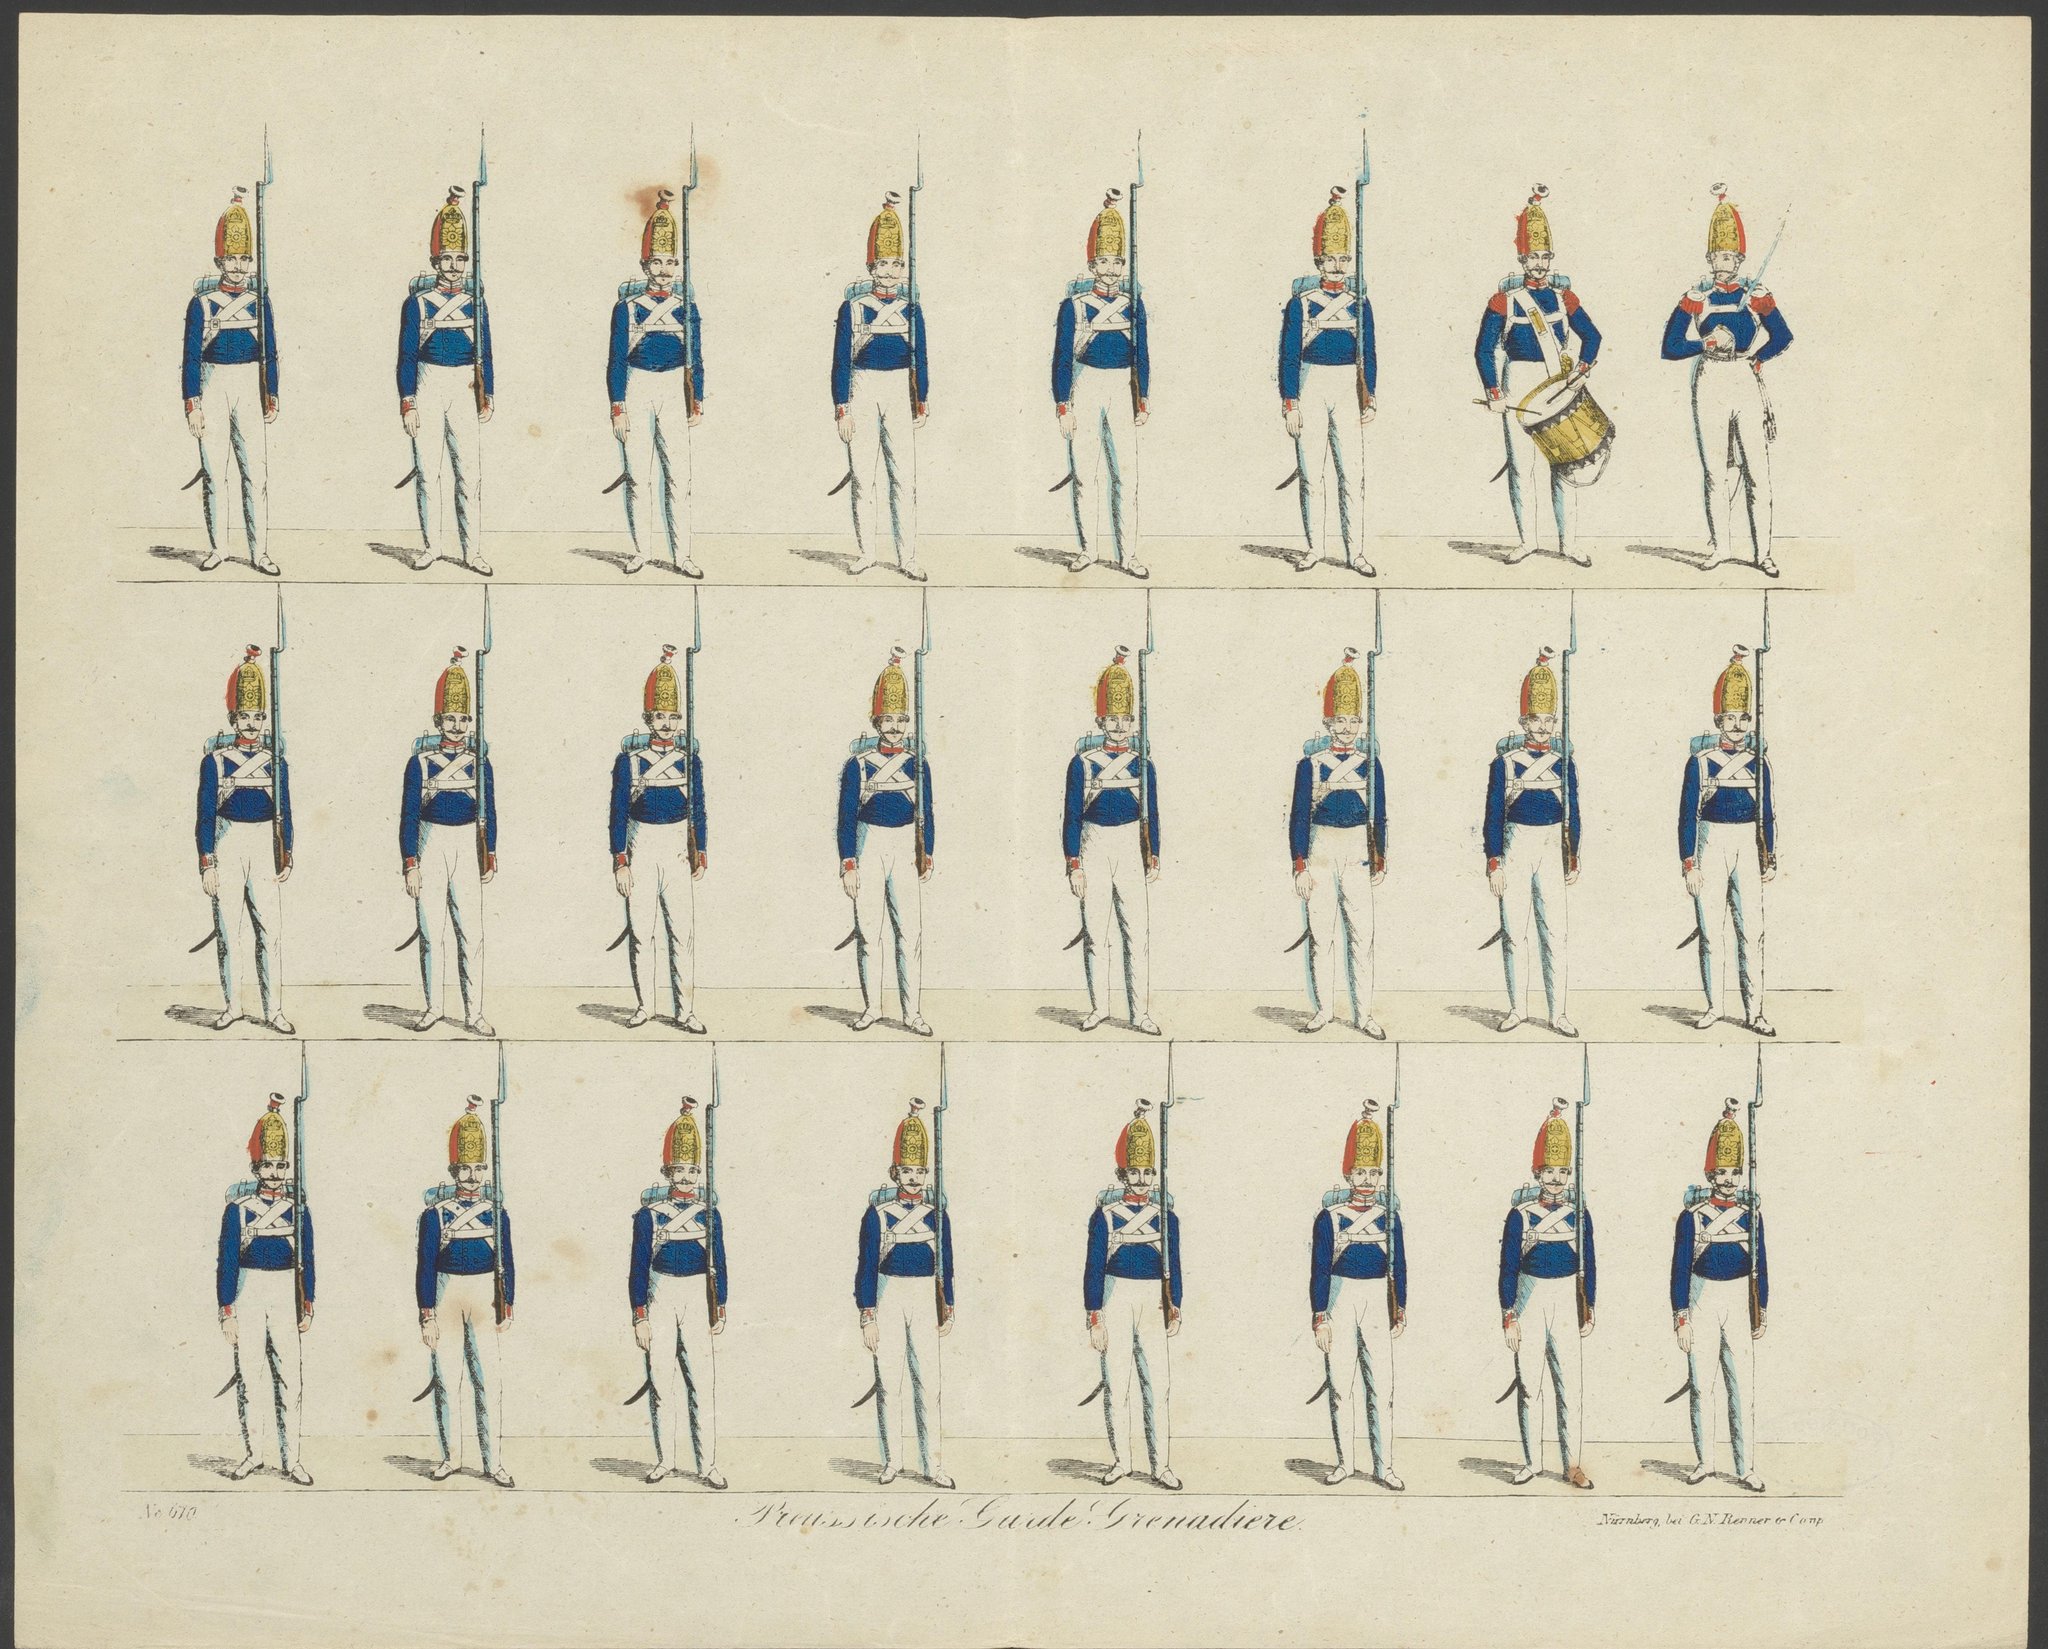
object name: print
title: Pruisische grenadiers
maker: Anonymous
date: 1837-1868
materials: paper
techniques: hand coloring, lithograph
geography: nuremberg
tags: the company, the unit, the troop ~ military service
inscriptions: stamp, collector's mark: Lugt 1641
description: Onderaan genummerd: No. 670. Onderwerpsrubrieken binnen de Atlas Zeden en Gewoonten: Zeden en Gewoonten in Engeren Zin, Des menschen beging, midden en einde, Kinderleven – Kinderspel en Kinderprenten.